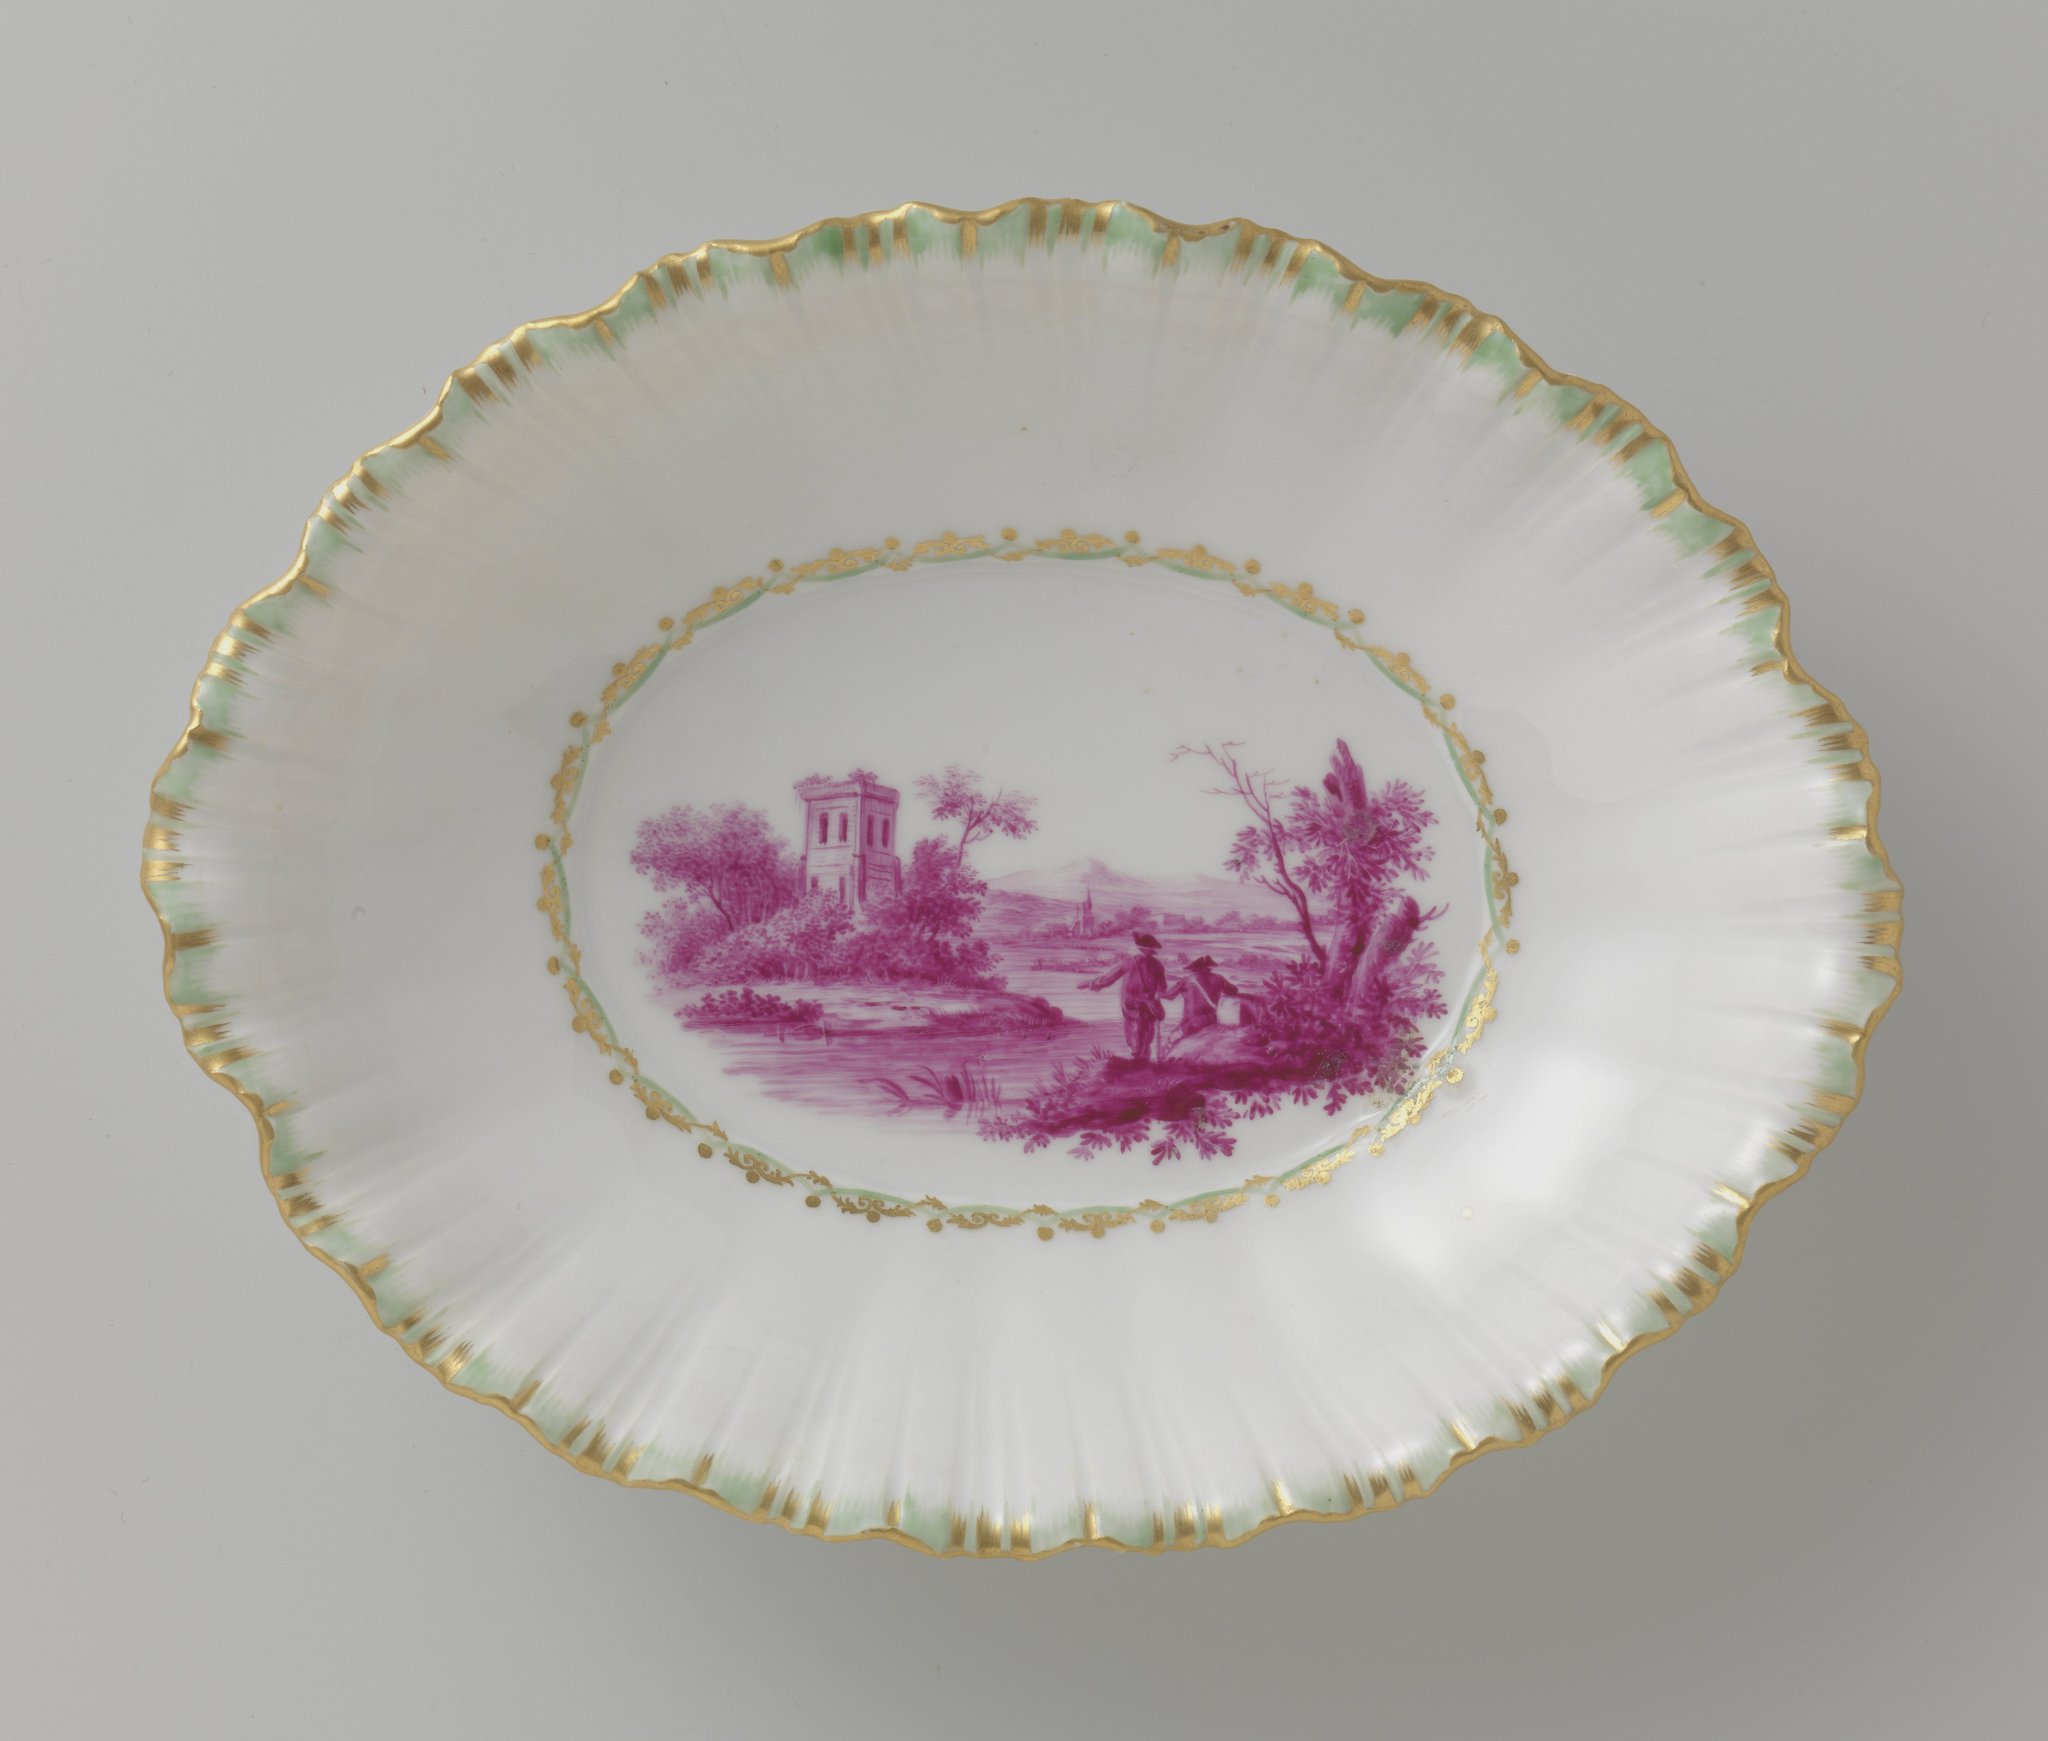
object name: dish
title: Ewer and basin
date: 1778-1782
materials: porcelain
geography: loosdrecht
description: Manufactuur Oud-Loosdrecht Loosdrecht, c. 1778–1782 hard-paste porcelain